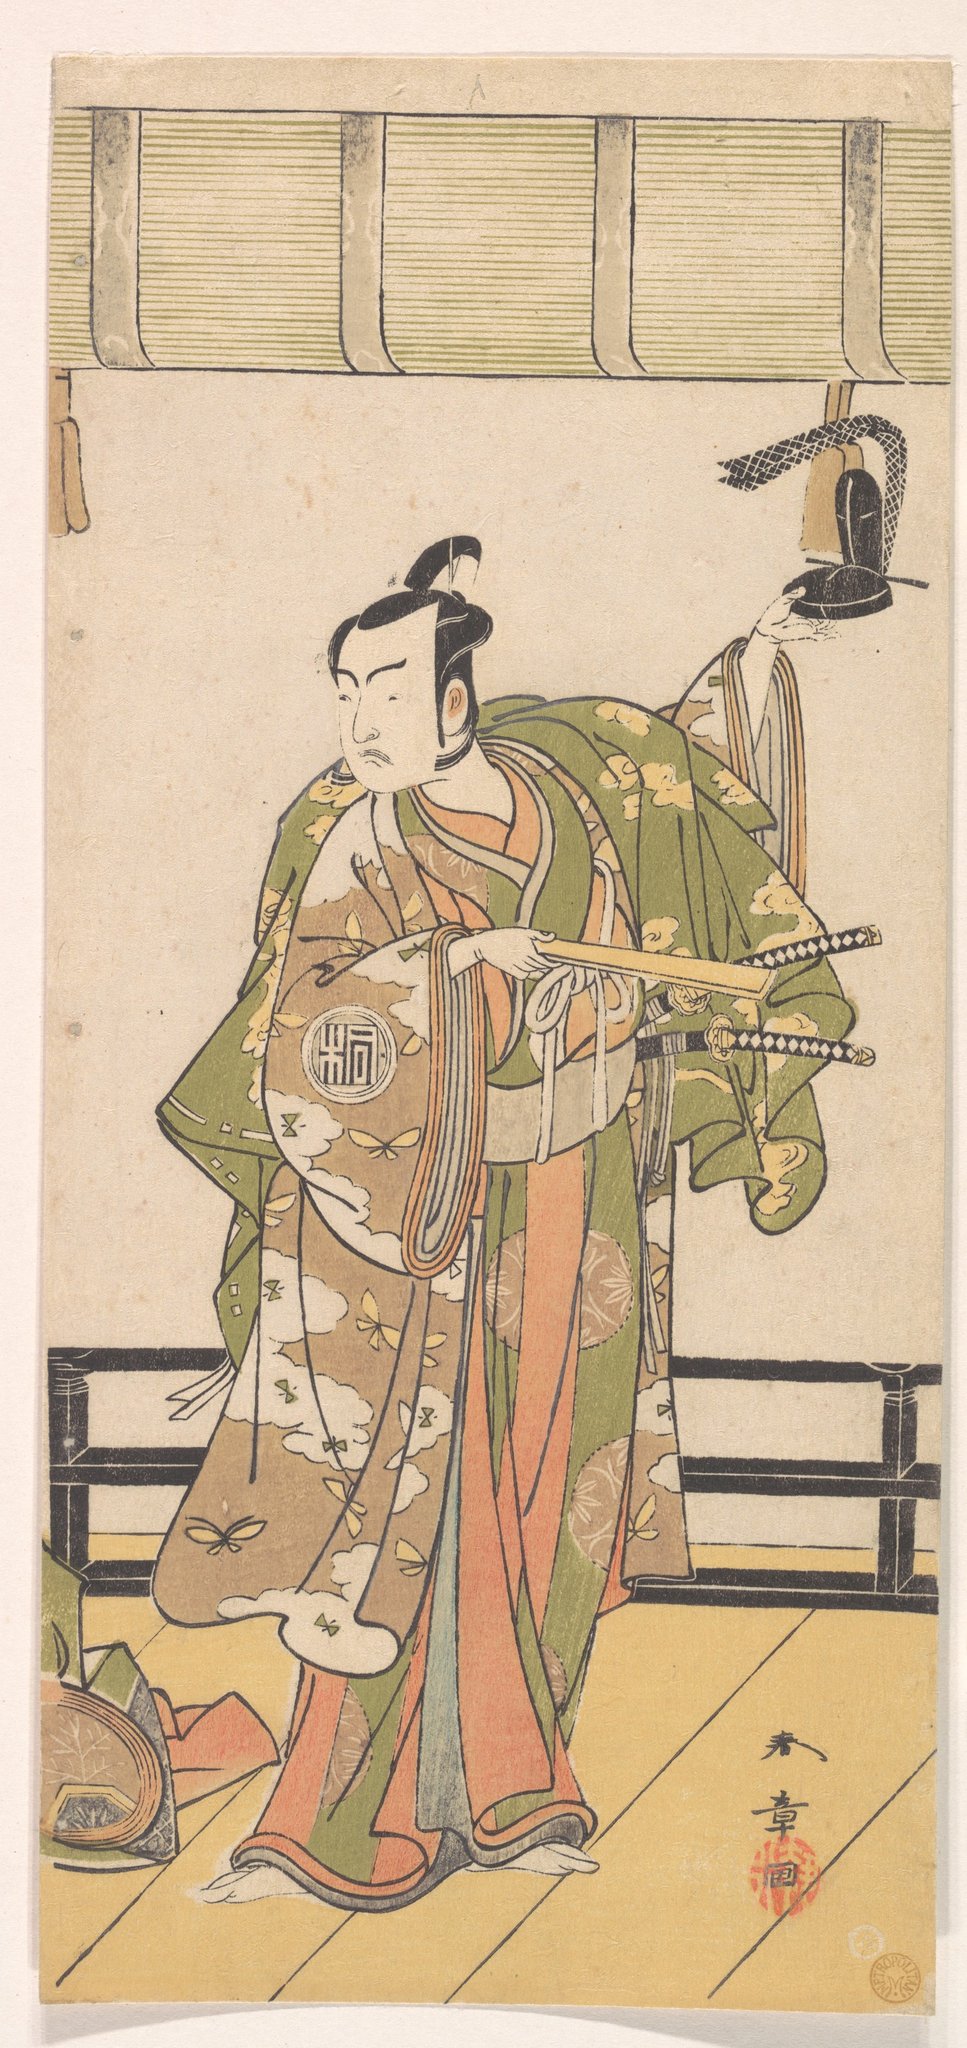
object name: woodblock print nishiki e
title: Arashi Sangoro as a Samurai Standing on the Veranda of a Great House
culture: japanese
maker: katsukawa shunshō 勝川春章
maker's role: artist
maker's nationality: japanese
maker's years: 1726-1792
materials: ink, paper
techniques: nishiki e, woodblock print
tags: men,actors